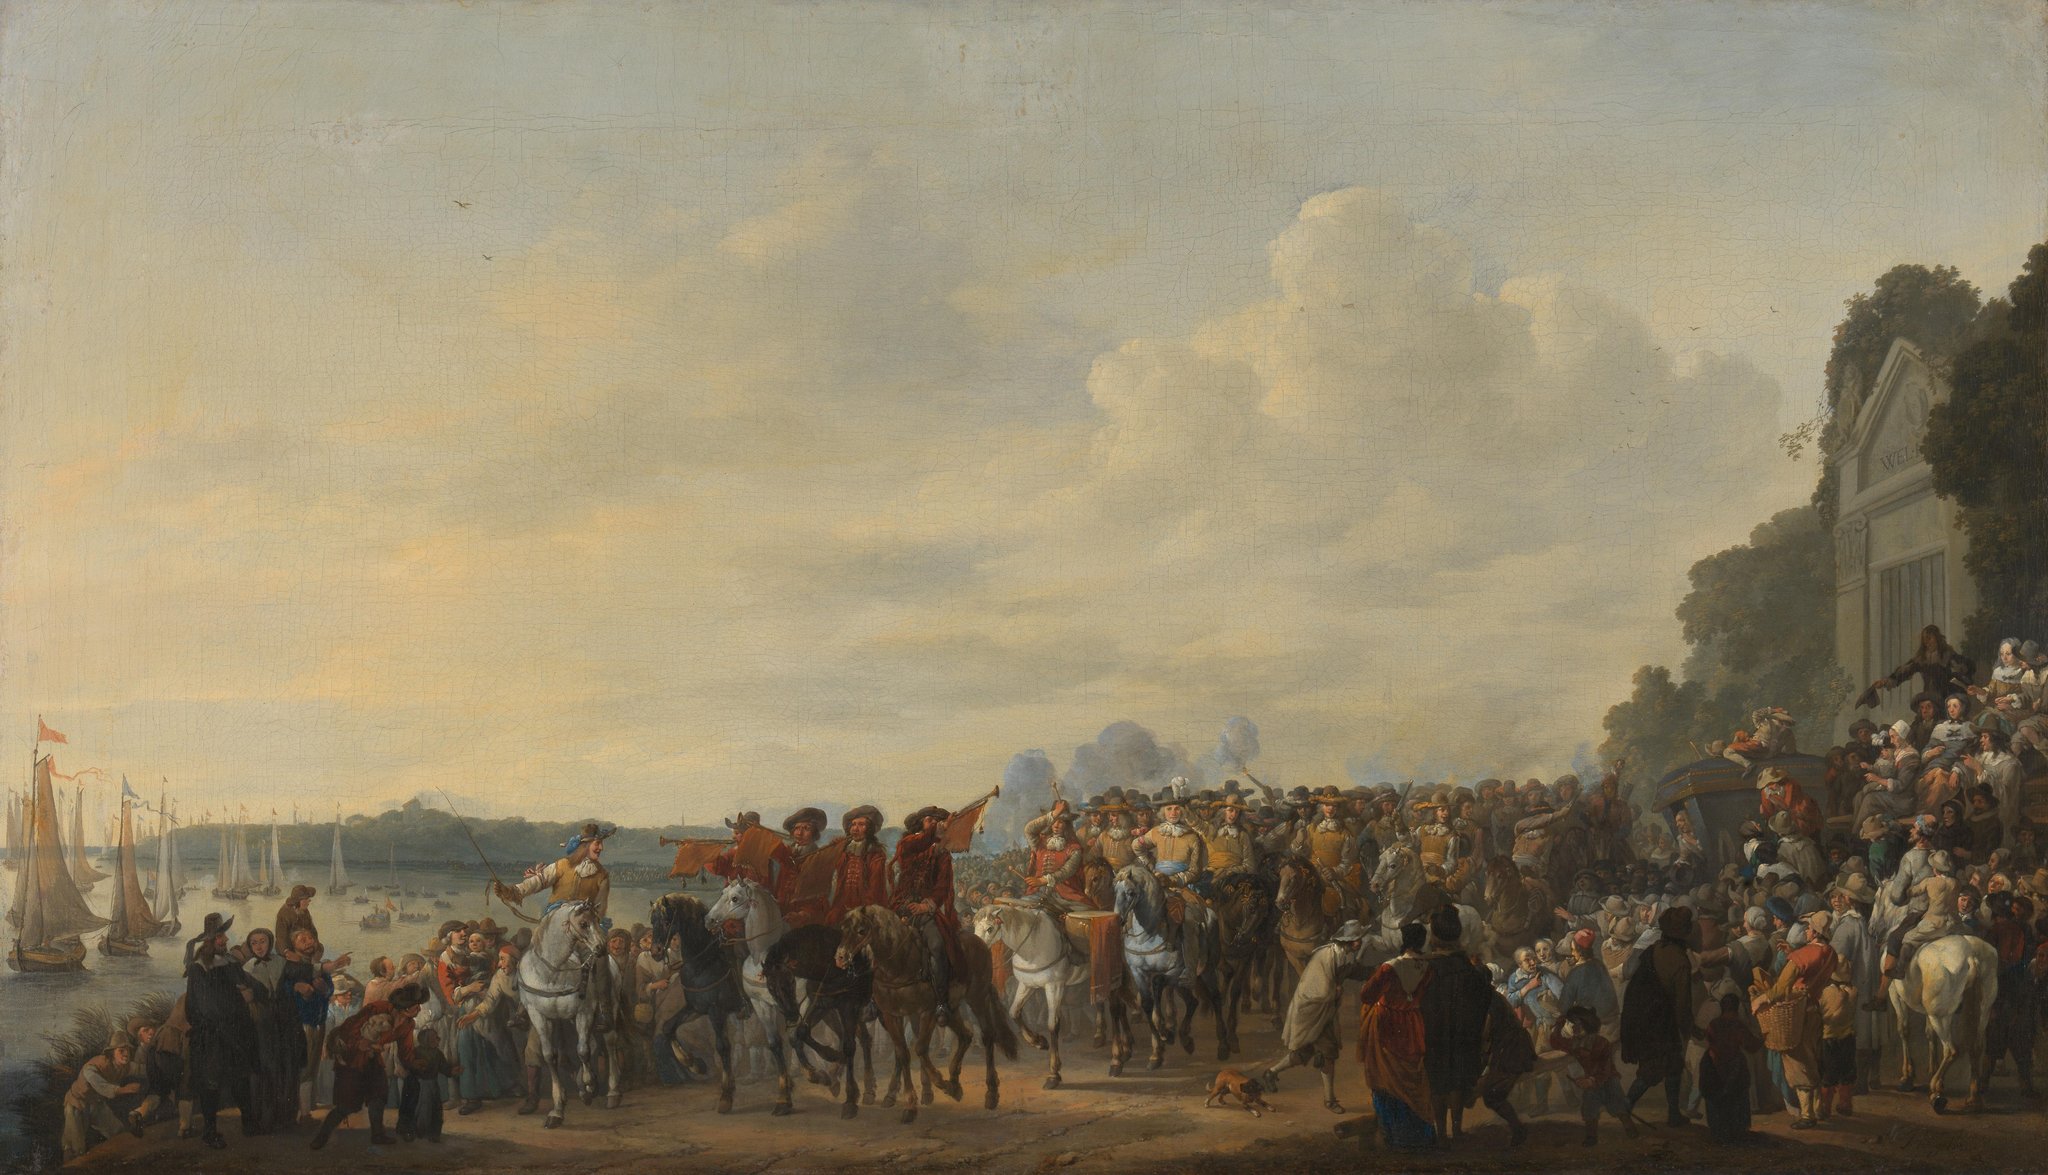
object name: painting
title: Charles II Halting at the Estate of Wema on the Rotte during his Journey from Rotterdam to The Hague, 25 May 1660; or (less probably) the troops of Prince Willen II halting at the estate of Welna on the Amstel during their March on Amsterdam, 31 May-4 August 1650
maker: johannes lingelbach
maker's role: draughtsman, painter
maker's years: 1622-1674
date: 1650-1674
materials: canvas, oil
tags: william ii (prince of orange), troop movements, transportation, historical persons, assembling of military forces; mobilization, troop concentration, etc.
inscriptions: signature: ‘J. Lingelbach’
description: Het halthouden van de oprukkende troepen bij de Hofstede Welna aan de Amstel tijdens de aanslag van prins Willem II op Amsterdam, 31 juli 1650. Een lange stoet van ruiters wordt voorafgegaan door herauten en tamboers. Links en rechts is de bevolking toegestroomd om het schouwspel gade te slaan. Links een rivier met boten. Rechts een gebouw met op de gevel de naam beginnend met de letters WEL. Pendant van SK-C-1224.